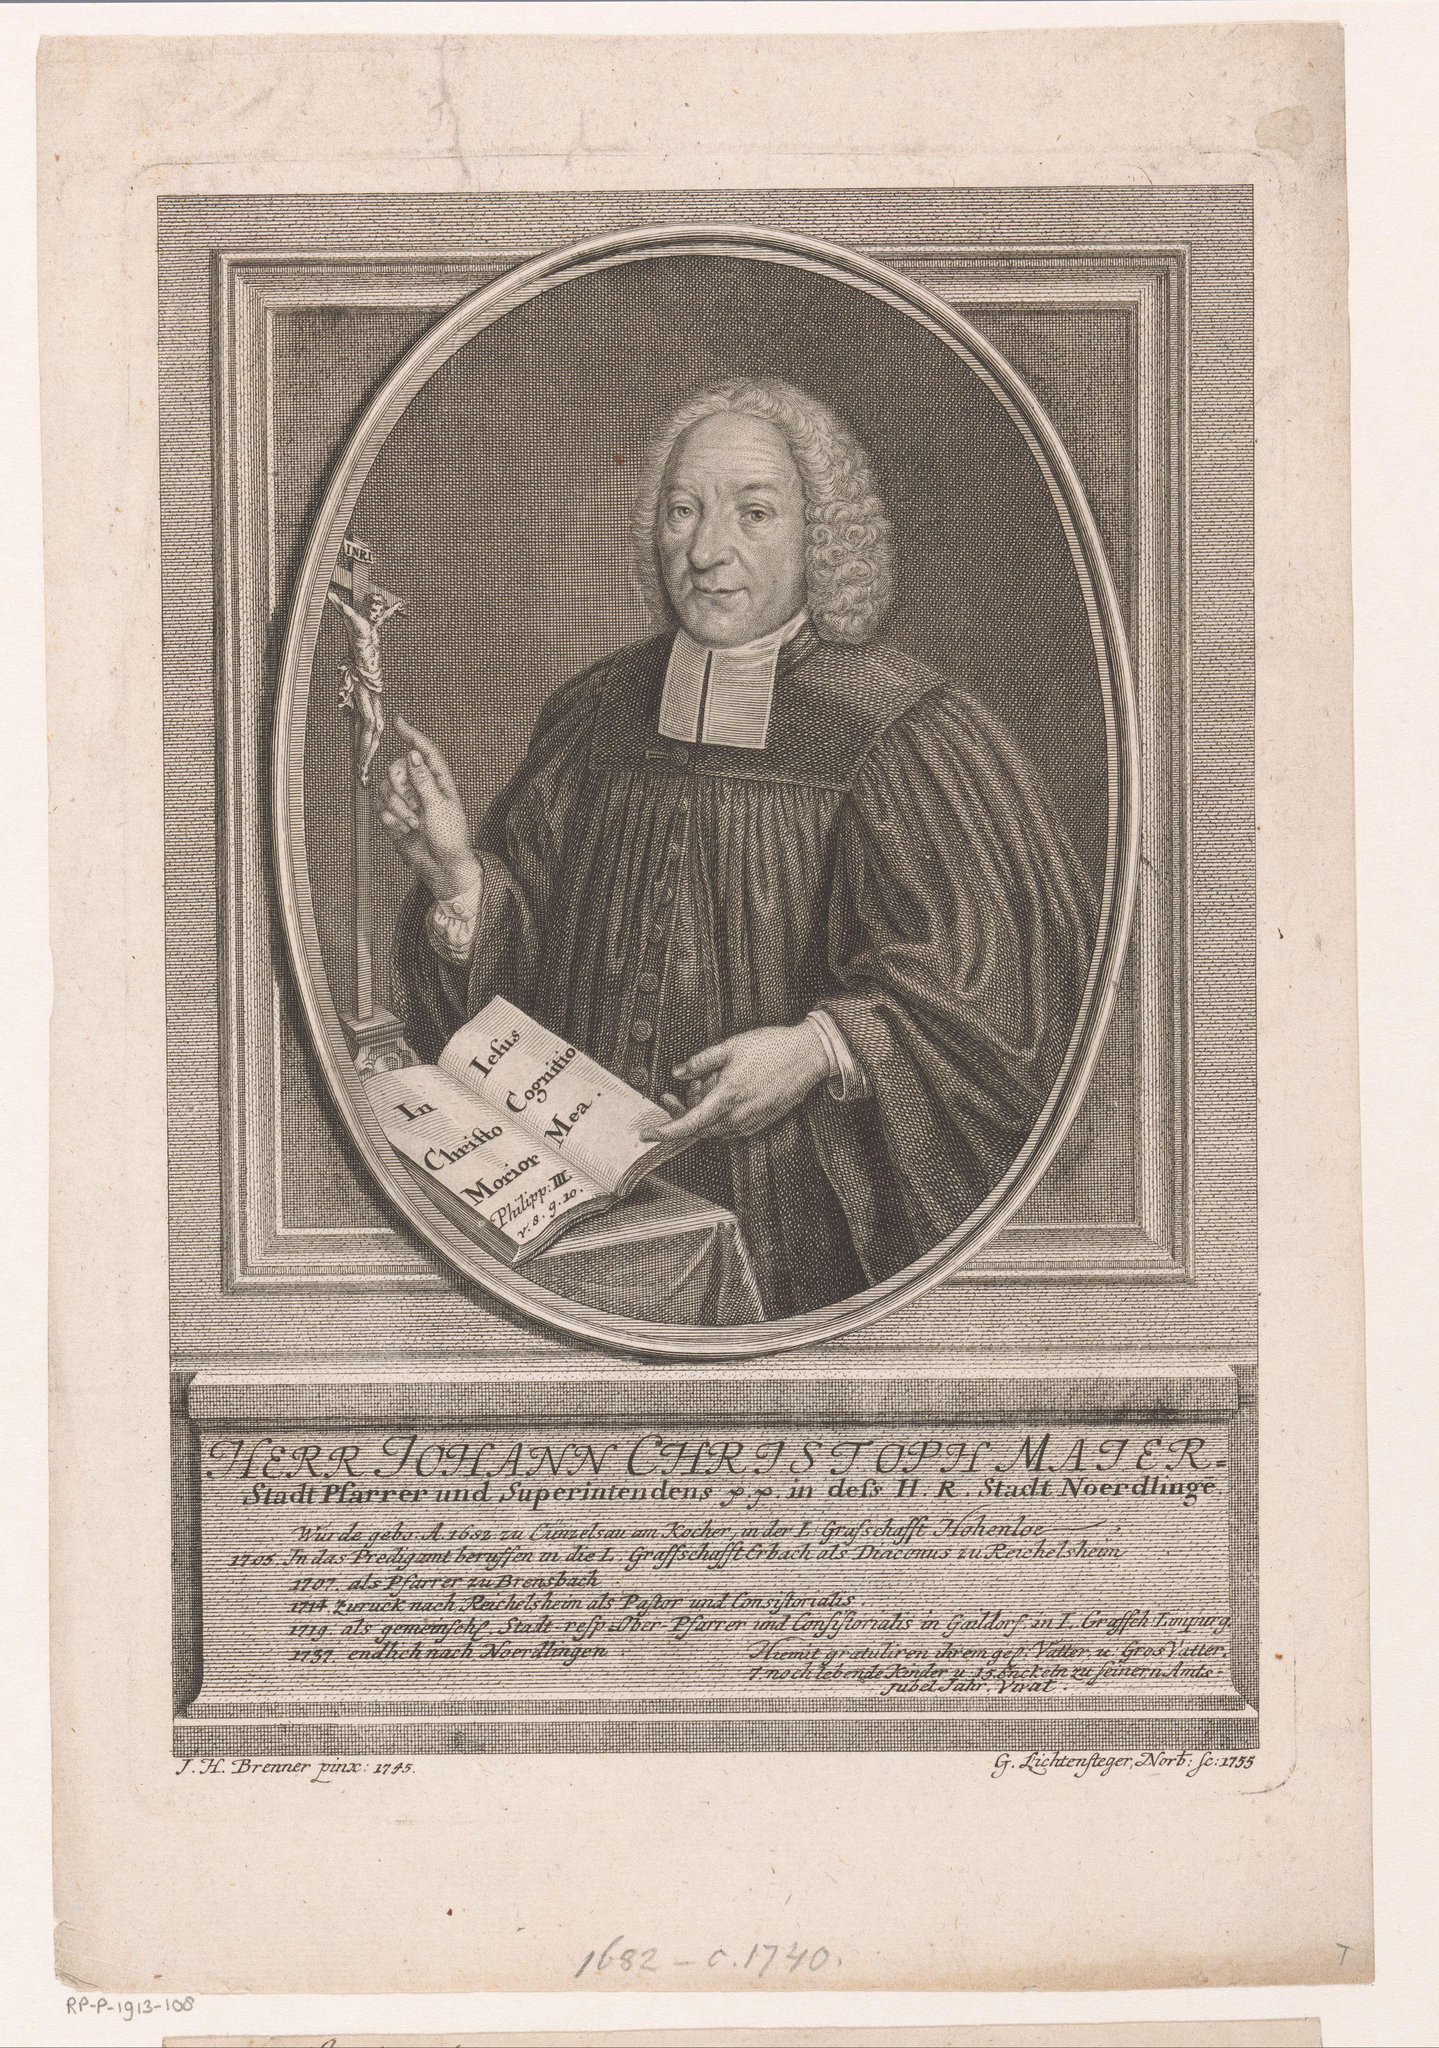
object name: print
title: Portret van Johann Christoph Maier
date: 1755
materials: paper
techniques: engraving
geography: nuremberg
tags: historical persons, book - mm - book open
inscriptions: collector's mark: Lugt 2228